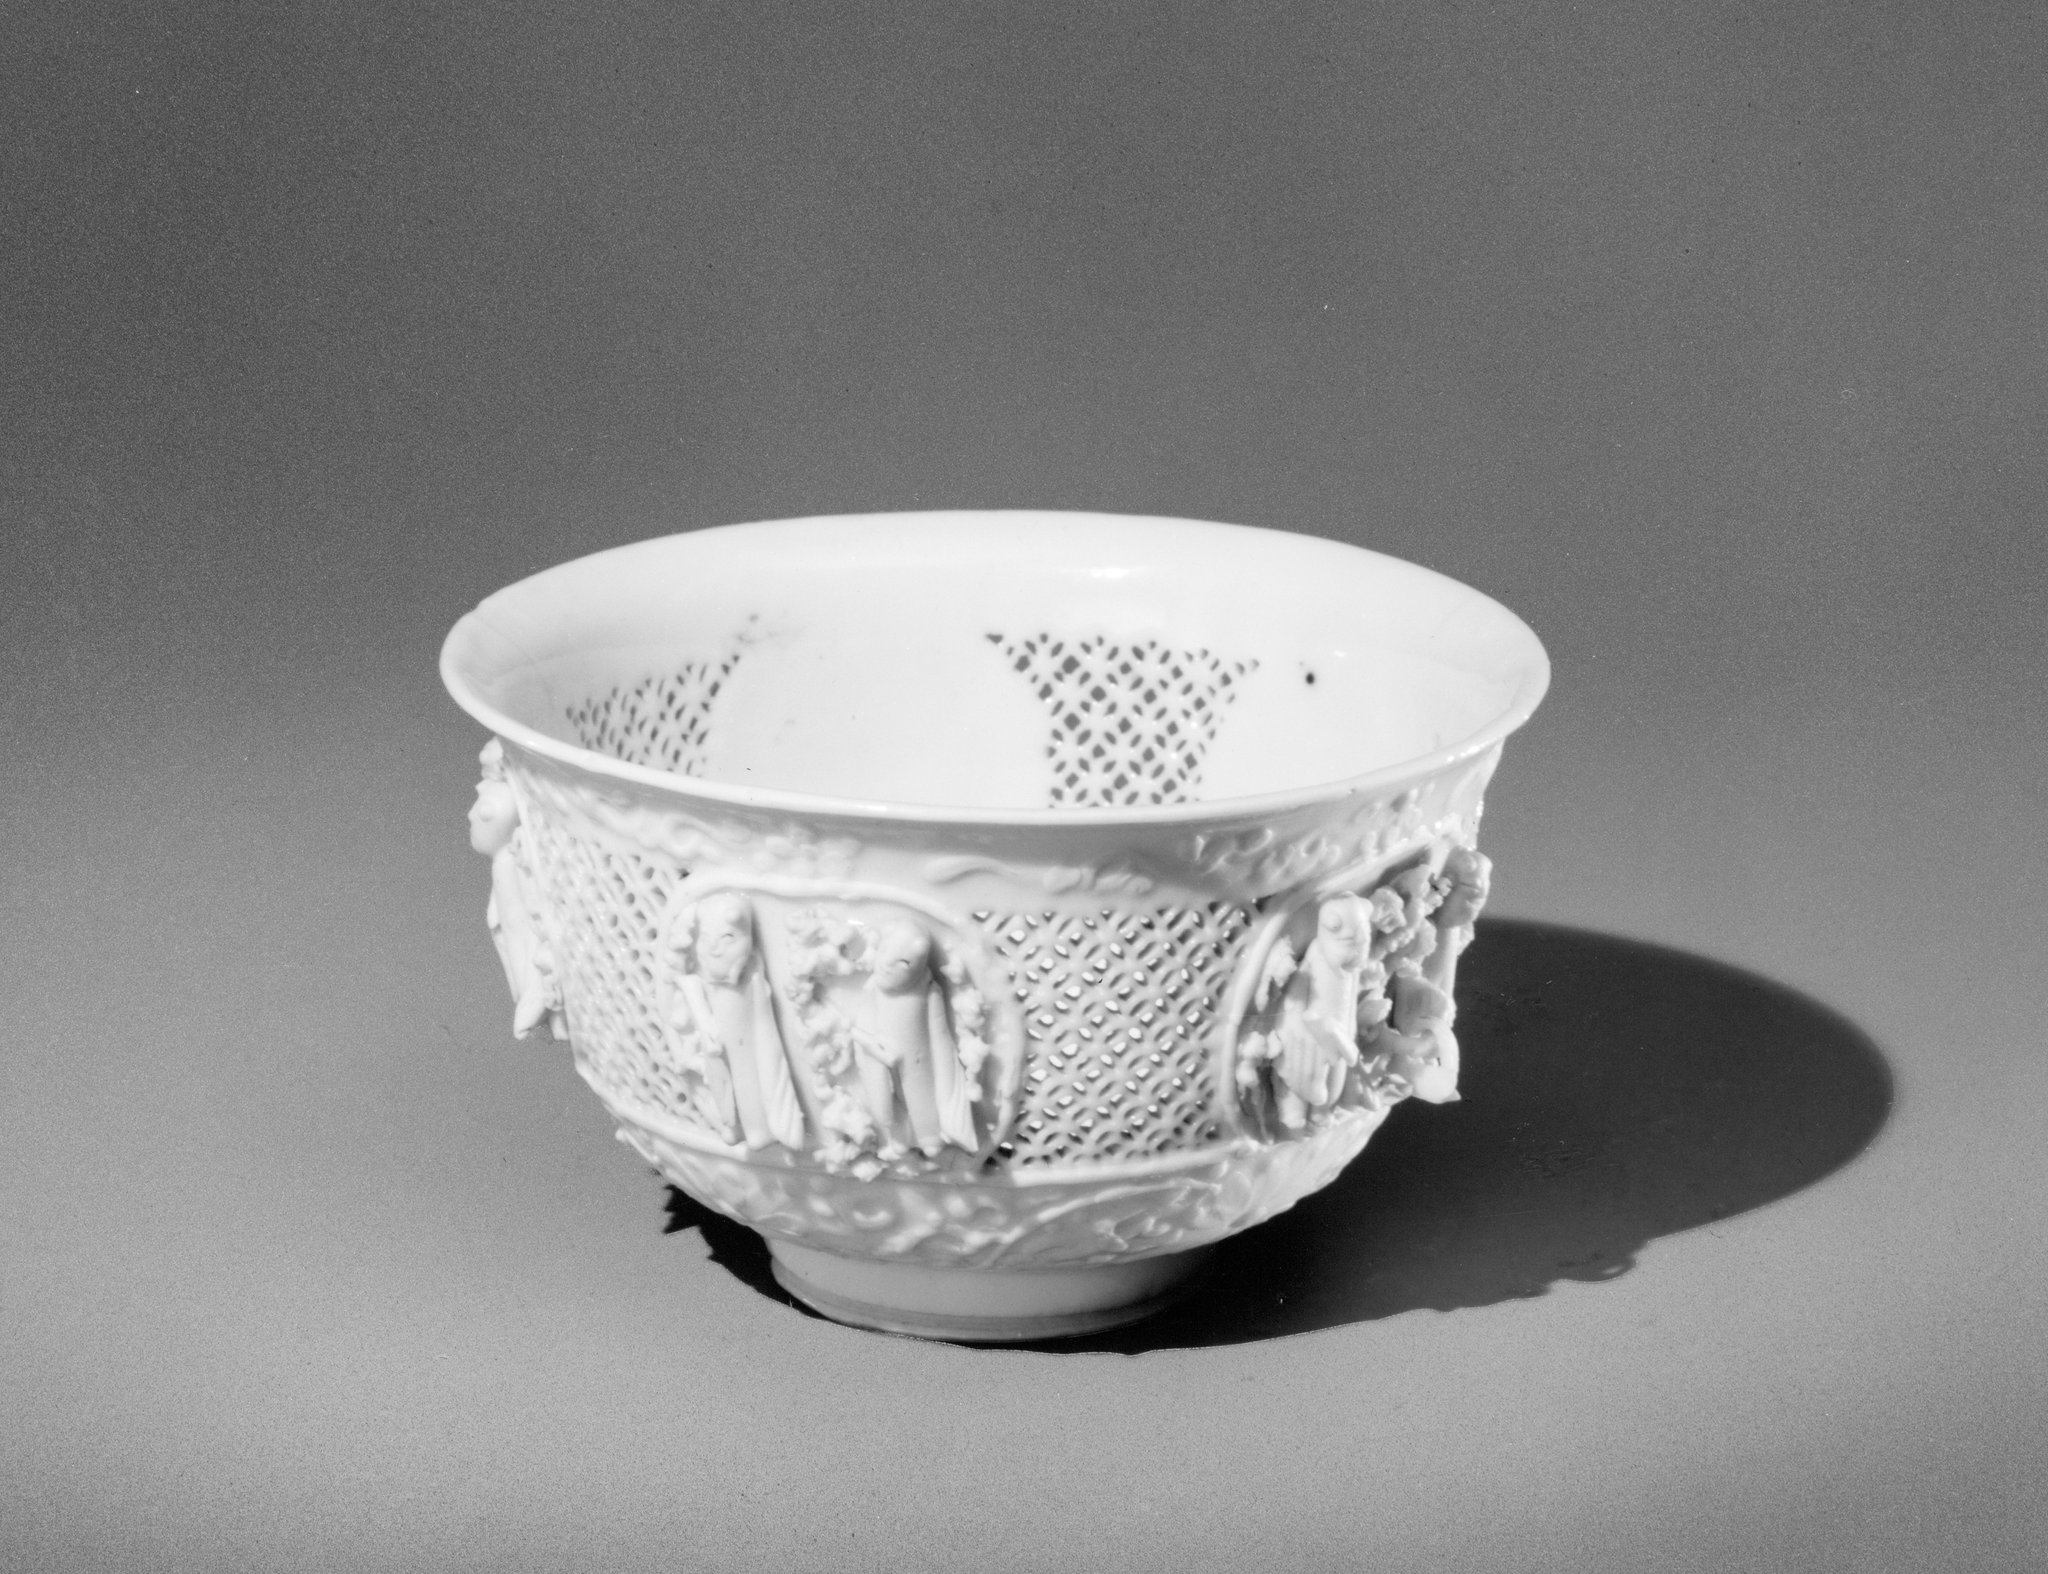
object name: bowl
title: Bowl (one of a pair)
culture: chinese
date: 1567-1700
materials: biscuit, glaze, porcelain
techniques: relief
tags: human figures